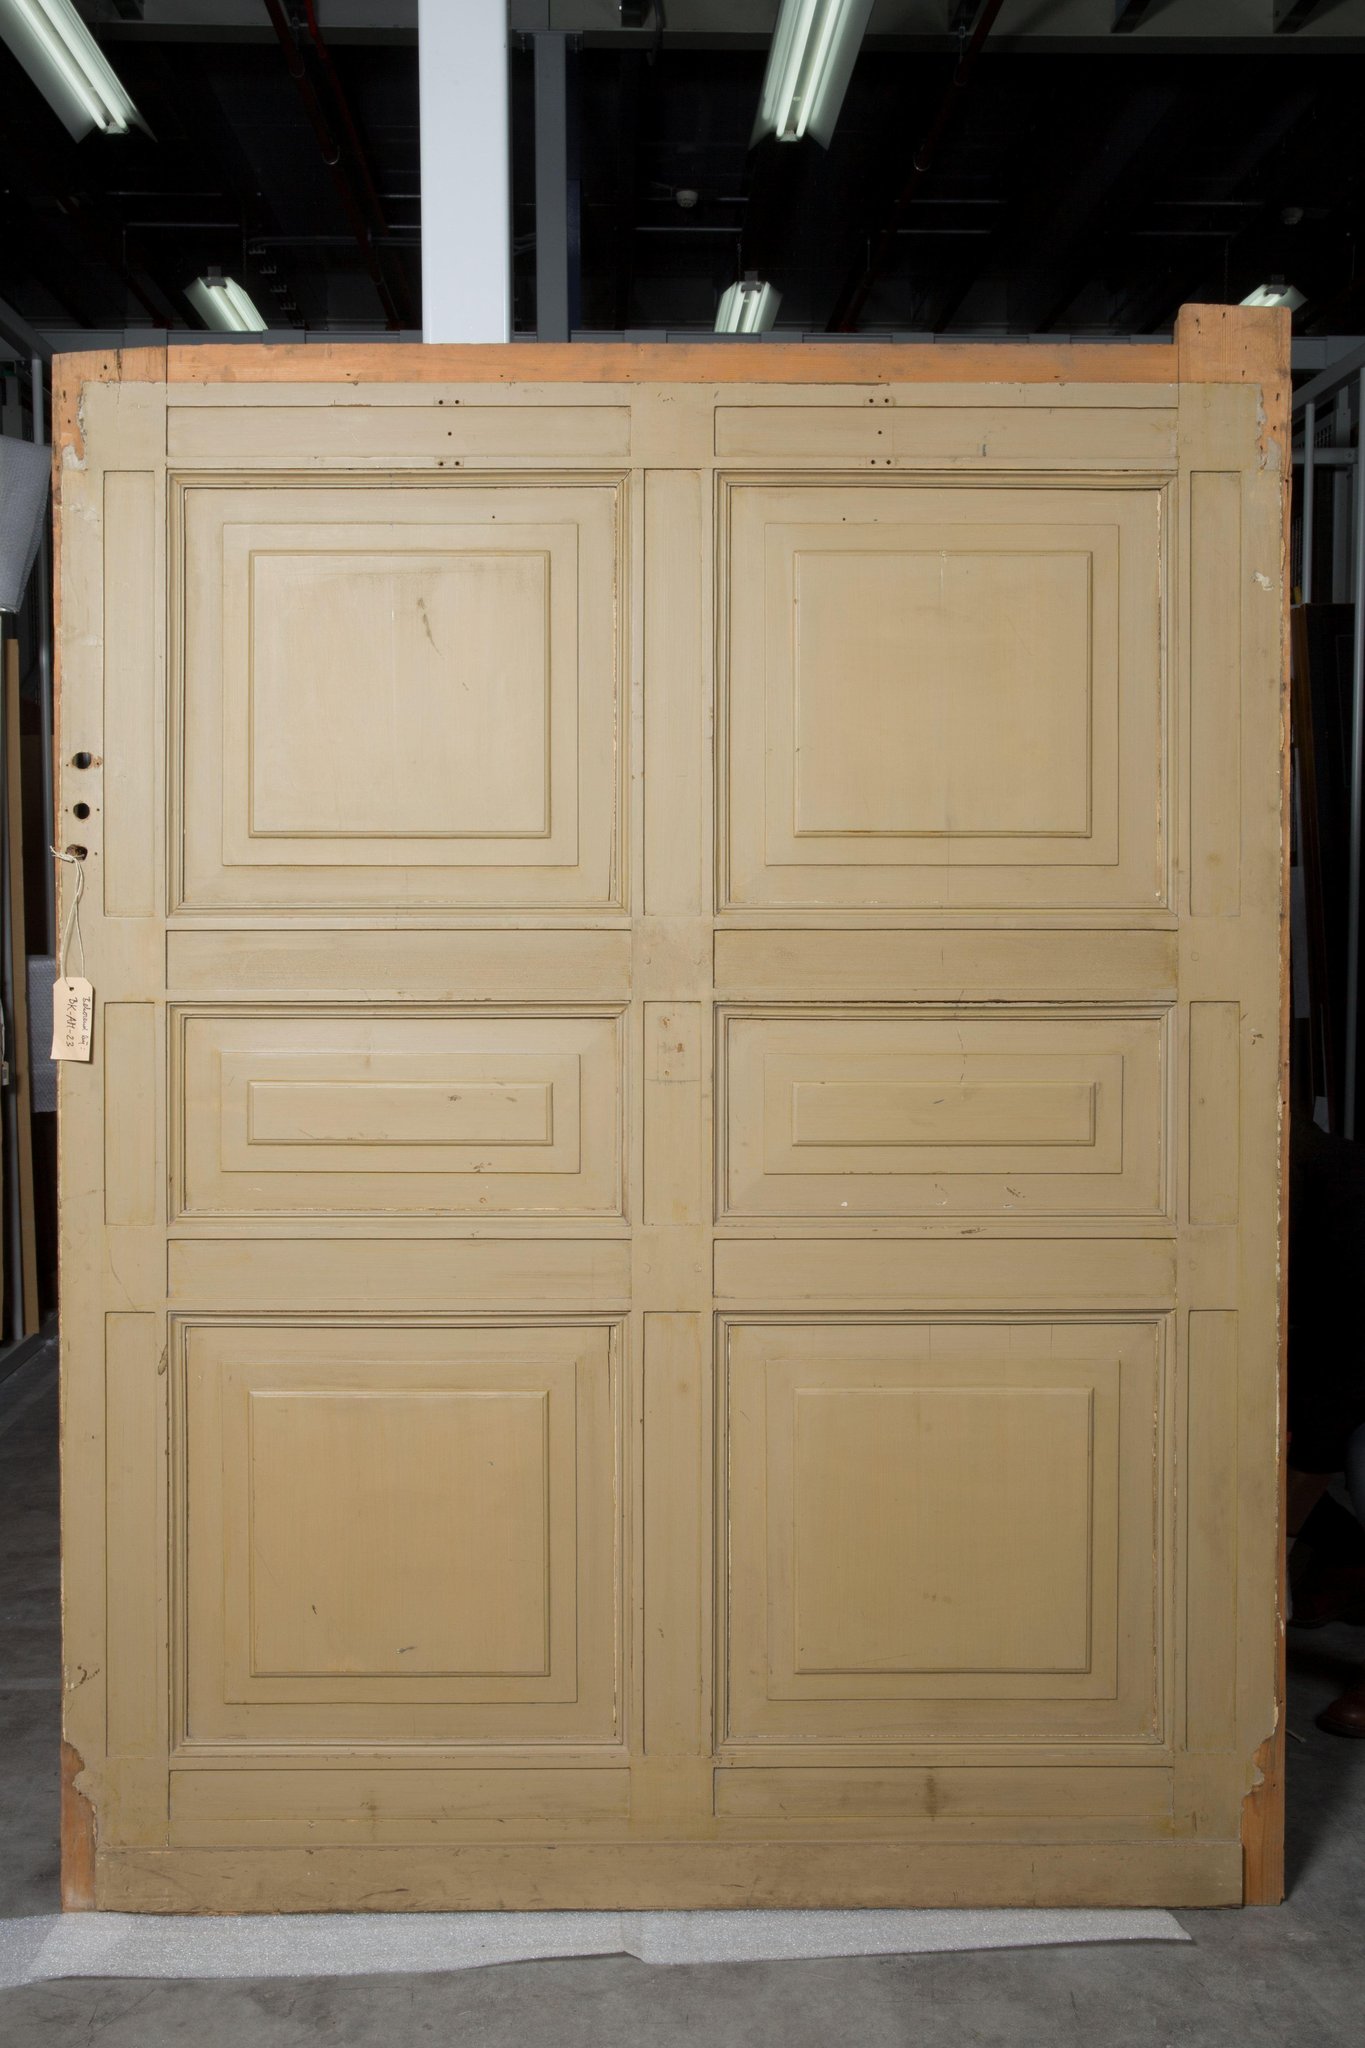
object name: betimmering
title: Betimmering, deel. Fries met opengewerkte ranken met draken. Vooruitspringend deel met twee deuren met kussenpaneel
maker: Anonymous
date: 1665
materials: wood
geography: northern netherlands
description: Gedeelte van een betimmering van eikenhout, geschilderd, bestaande uit twee naar voren springende vakken en een wandvak. Het hoofdgestel wordt gedragen door pilasters. Het fries is versierd met opengewerkte ranken met afgewende draken met toegewende koppen. Het vooruitspringende vak heeft twee deuren met staand kussenpaneel en raam versierd met rechthoekige uitgrondingen. Afkomstig van het Leprozenhuis te Amsterdam.